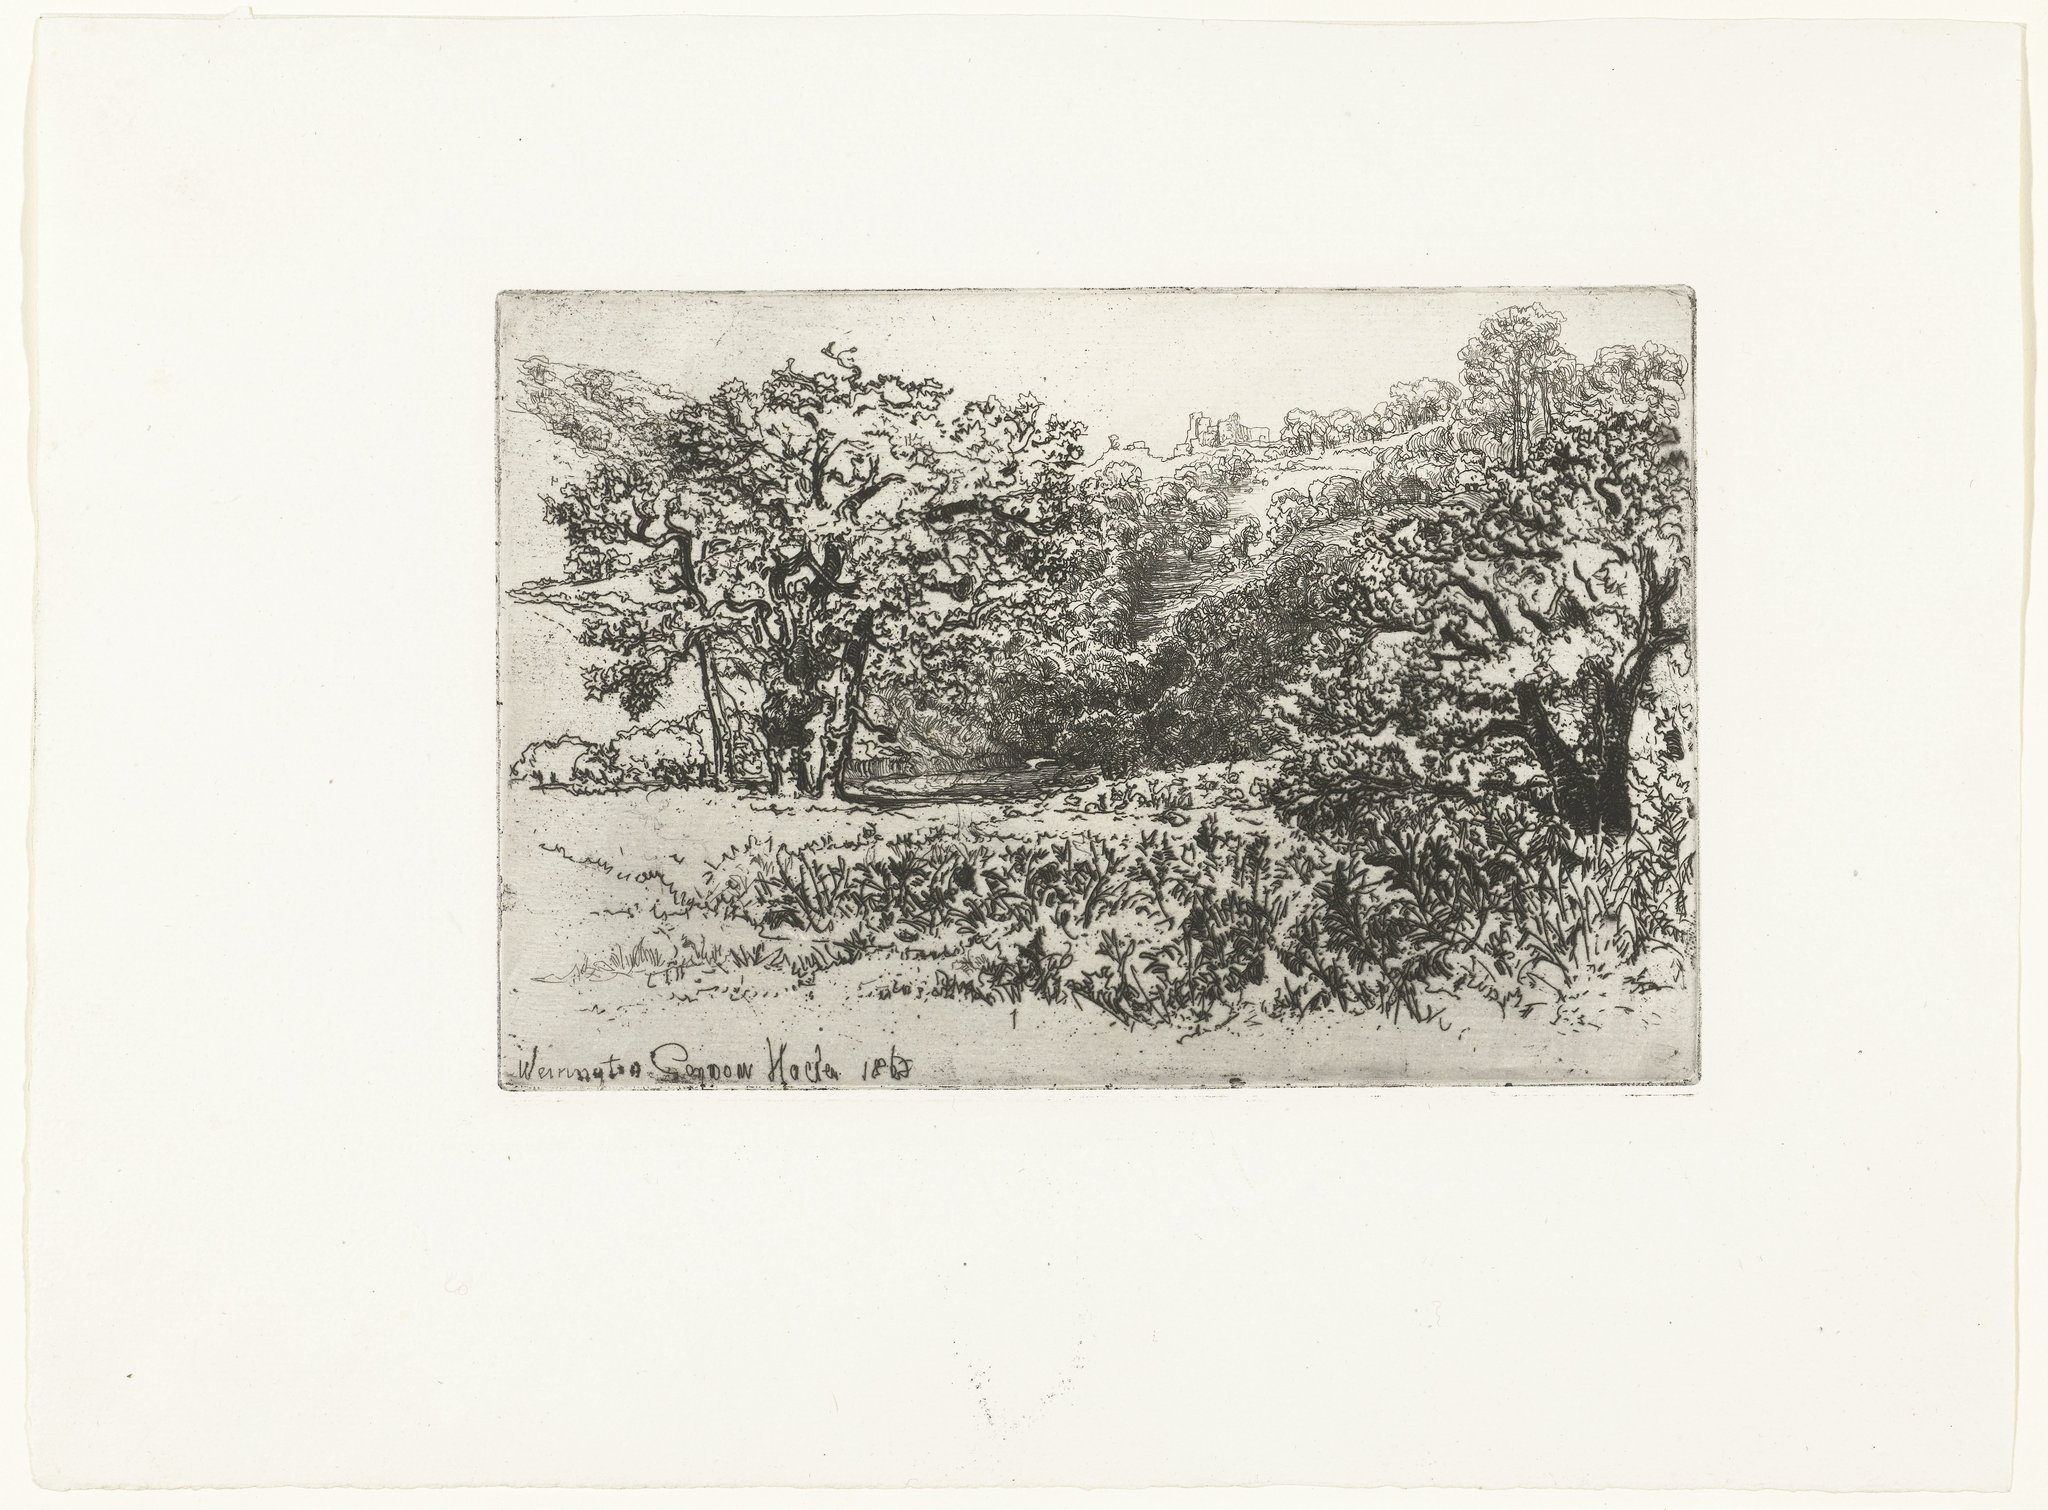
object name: print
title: The Herd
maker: francis seymour-haden (sir)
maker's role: print maker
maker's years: 1818-1910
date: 1868-1869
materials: paper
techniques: etching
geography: england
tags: (high) hill, animals (+ herd, group of animals)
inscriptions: collector's mark: Lugt 2228, collector's mark: Lugt 2760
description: Heuvelachtig landschap in de buurt van Werrington, met een kudde dieren bij een beek. In de verte op de heuvel een kasteel.